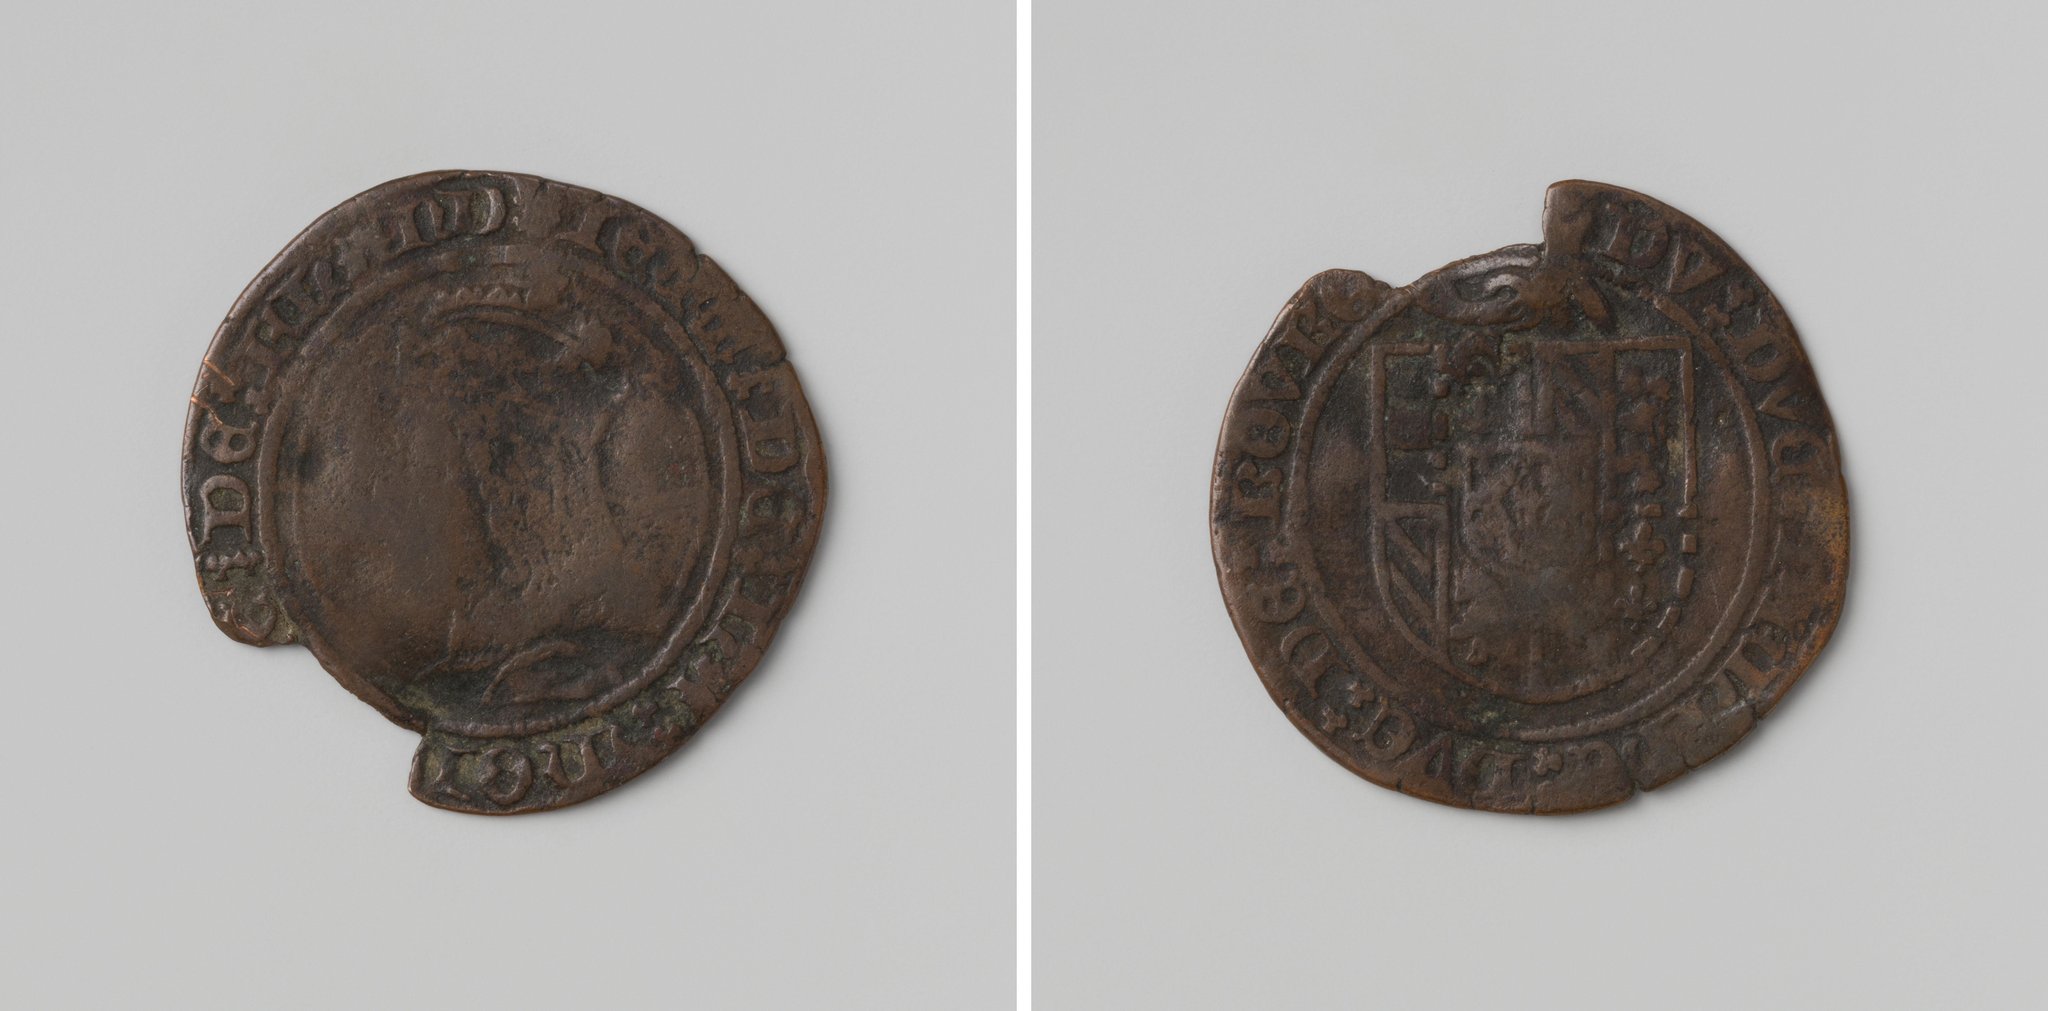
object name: jeton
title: Filips de Schone, hertog van Bourgondie, rekenpenning van de munt van Vlaanderen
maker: Anonymous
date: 1491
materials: copper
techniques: striking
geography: flanders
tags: bruges, filips de schone (hertog van bourgondië)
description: Koperen penning. Voorzijde: borststuk man met kroon binnen omschrift. Keerzijde: wapenschild aan lint met knoop binnen omschrift